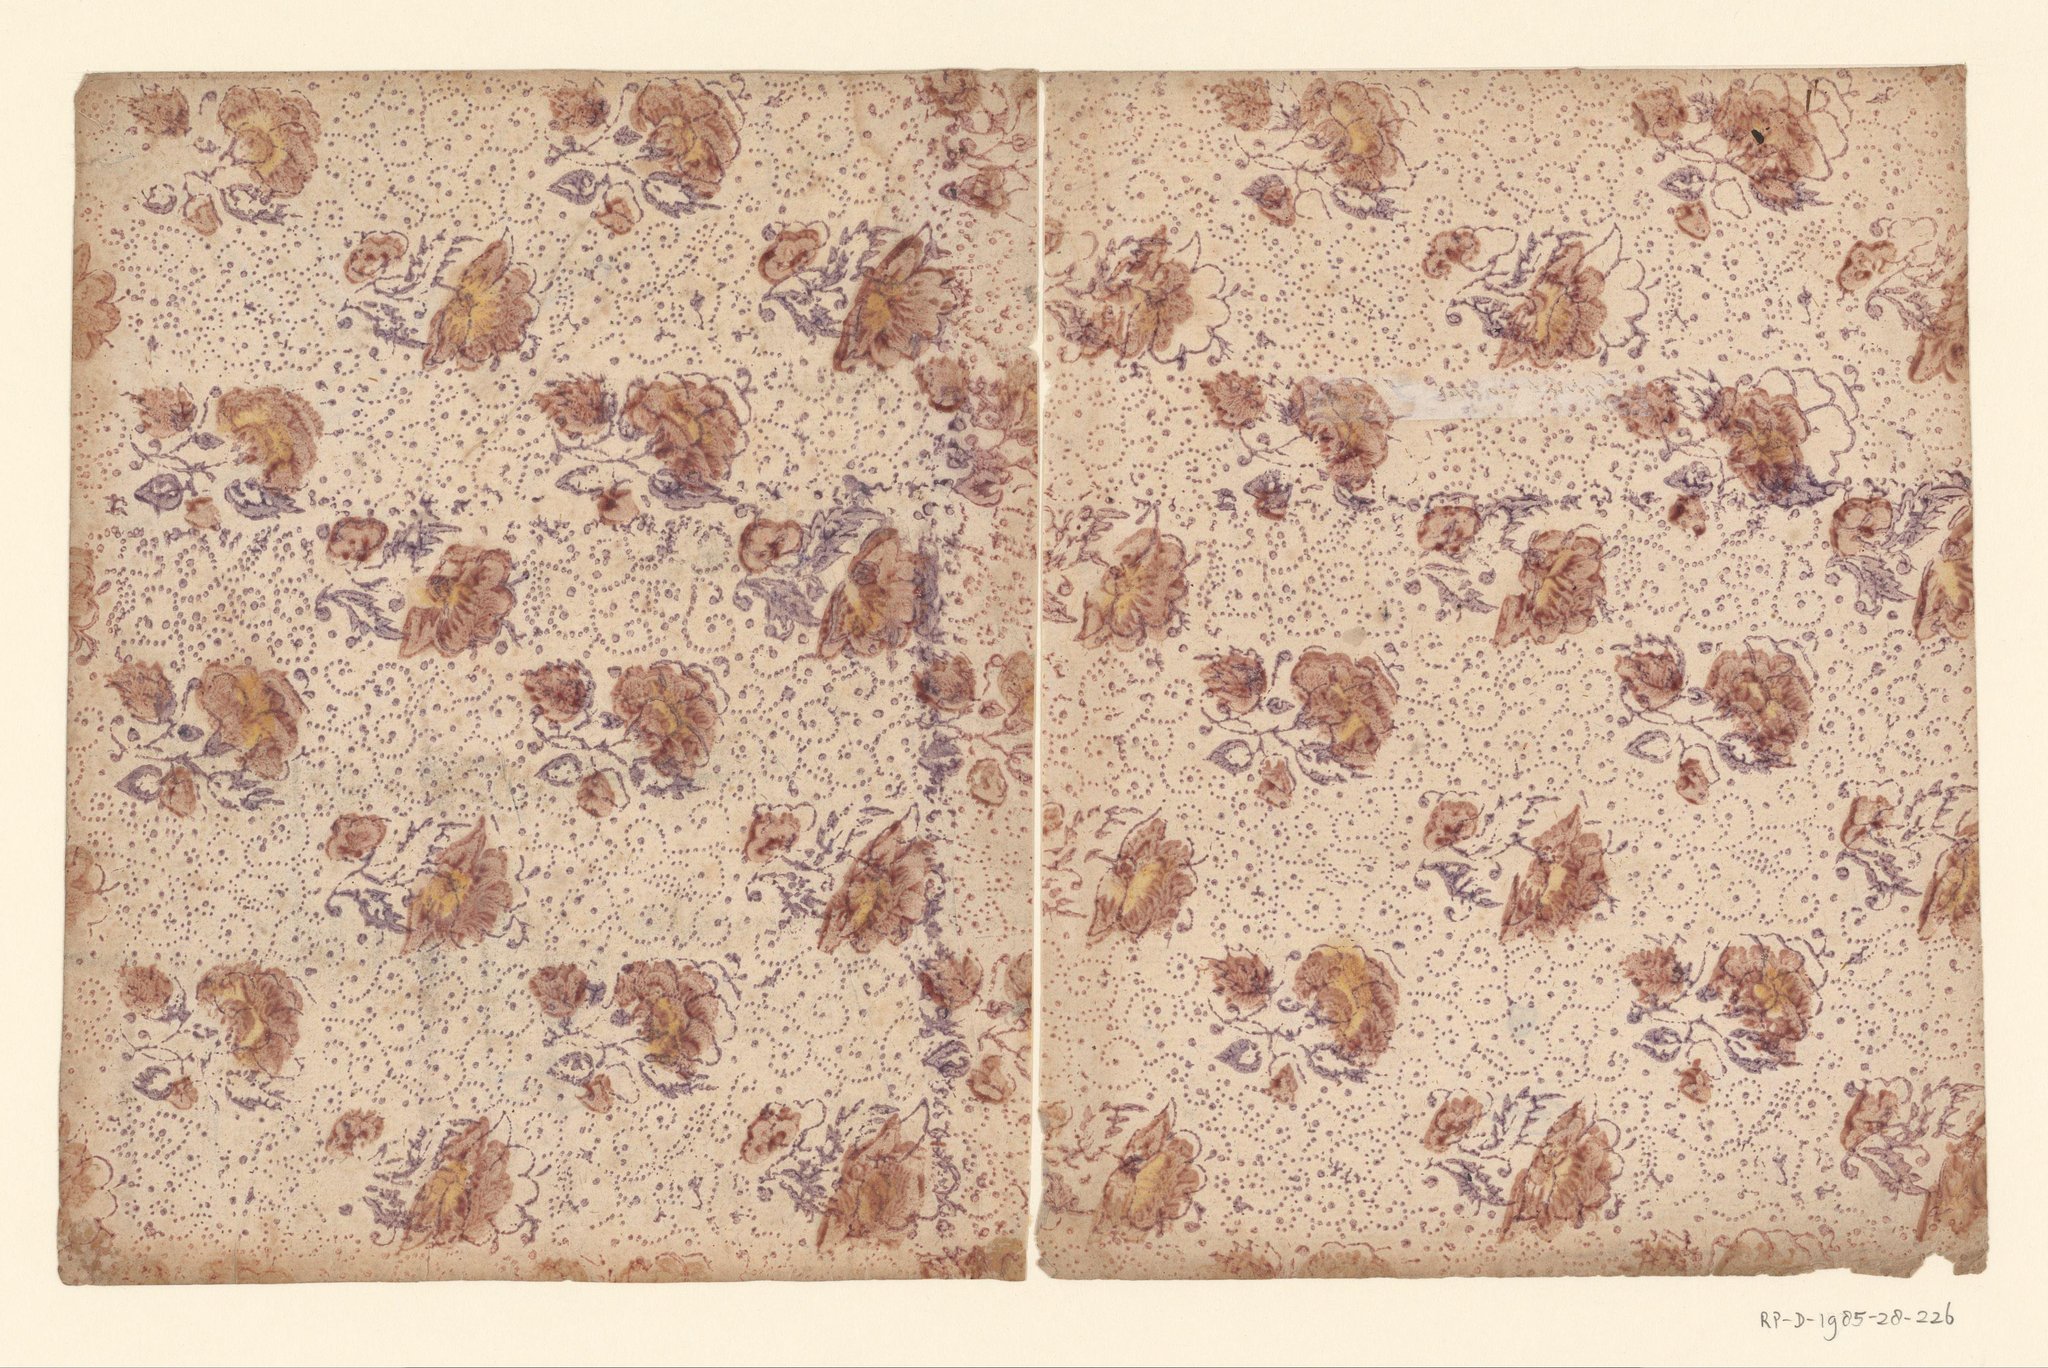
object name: printed paper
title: Twee bladen met strooipatroon van bloemen tussen ranken van punten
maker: Anonymous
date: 1750-1900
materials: paper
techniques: printing block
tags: ornament derived from plant forms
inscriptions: collector's mark: Lugt 2760, collector's mark: Lugt 2228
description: Twee bladen met strooipatroon van bloemen tussen ranken van punten. Met sporen van een verwijderd etiket. Twee losse helften van een omslag.